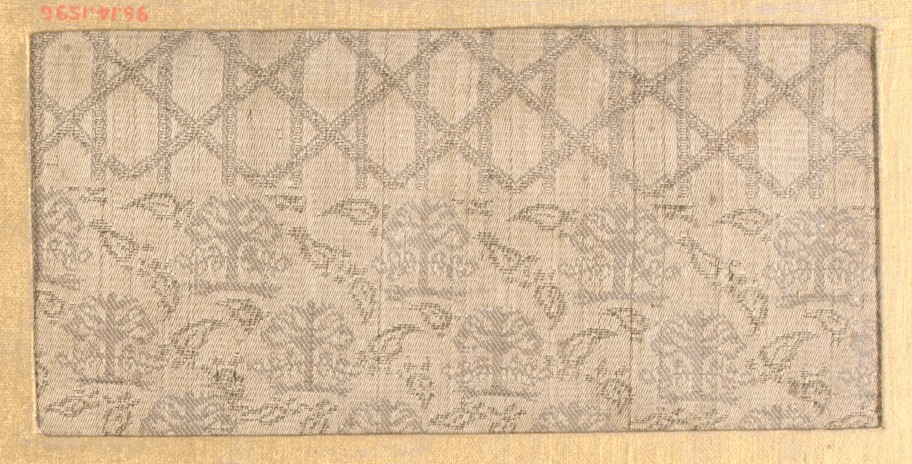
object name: piece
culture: japanese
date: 1701-1900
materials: silk